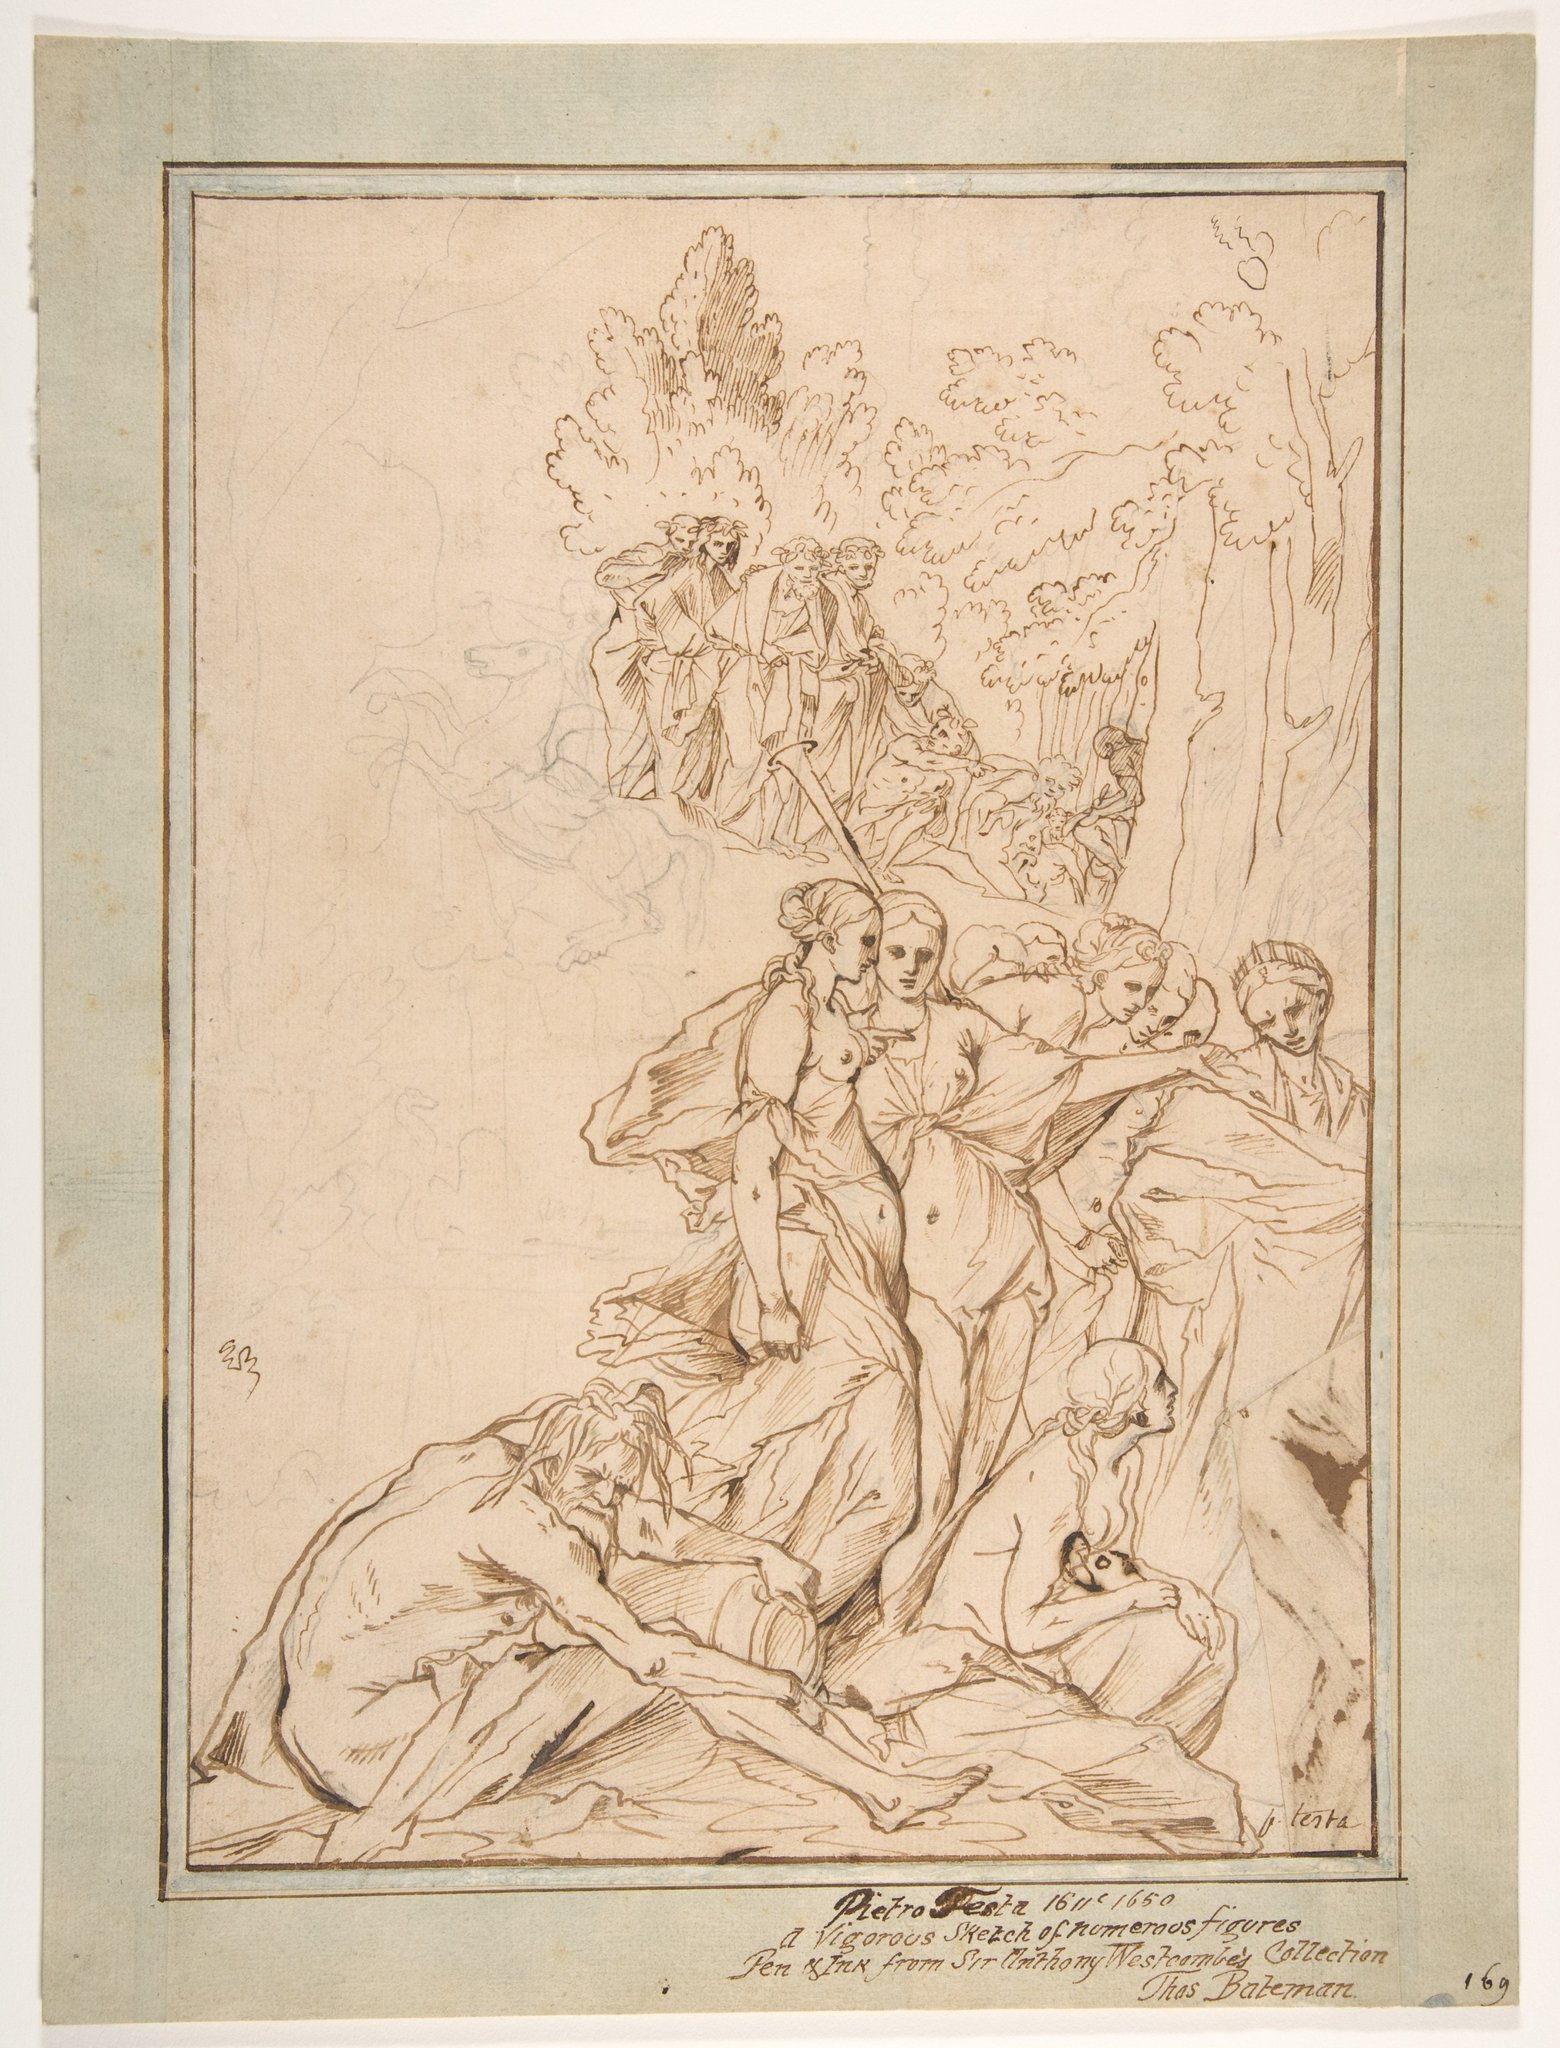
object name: drawing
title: Allegorical Figures on Mount Parnassus: Study for the etching Triumph of Painting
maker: pietro testa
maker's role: artist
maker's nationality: italian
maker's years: 1612-1650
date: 1612-1650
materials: chalk, ink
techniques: pen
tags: men,women,trees